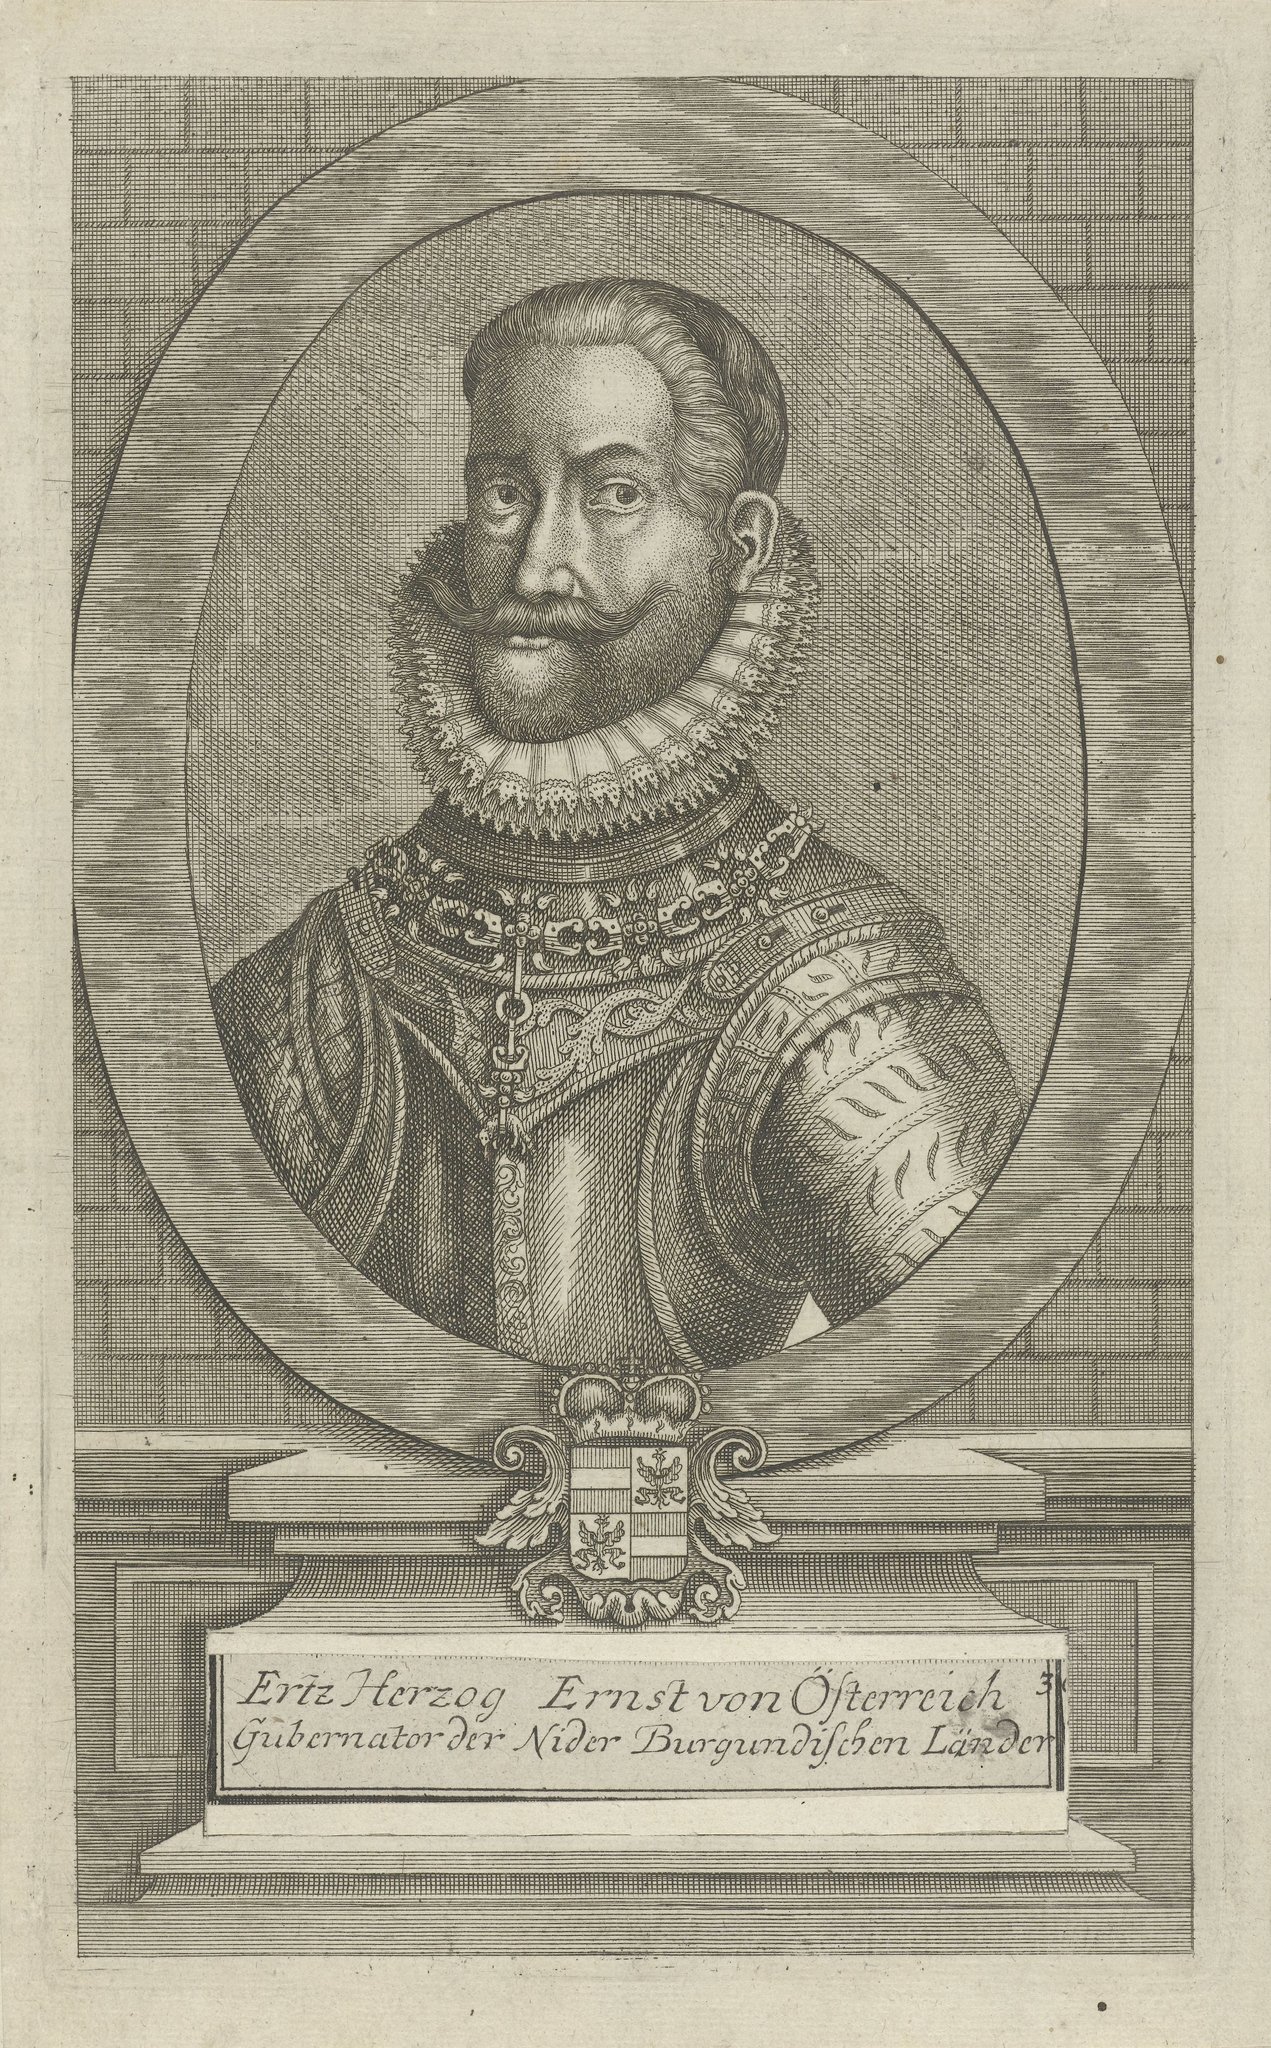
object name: print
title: Portret van Ernst van Oostenrijk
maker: jan lauwryn krafft (i)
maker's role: print maker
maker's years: 1694-1785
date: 1704-1765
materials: paper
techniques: engraving, etching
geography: southern netherlands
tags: brussels, historical persons, knighthood order of the golden fleece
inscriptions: collector's mark: Lugt 2228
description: Portretbuste van Ernst, aartshertog van Oostenrijk. Hij is blootshoofds en draagt een harnas. Om zijn nek een ketting met het teken van de orde van het Gulden Vlies. Op de plint zijn naam en titel.